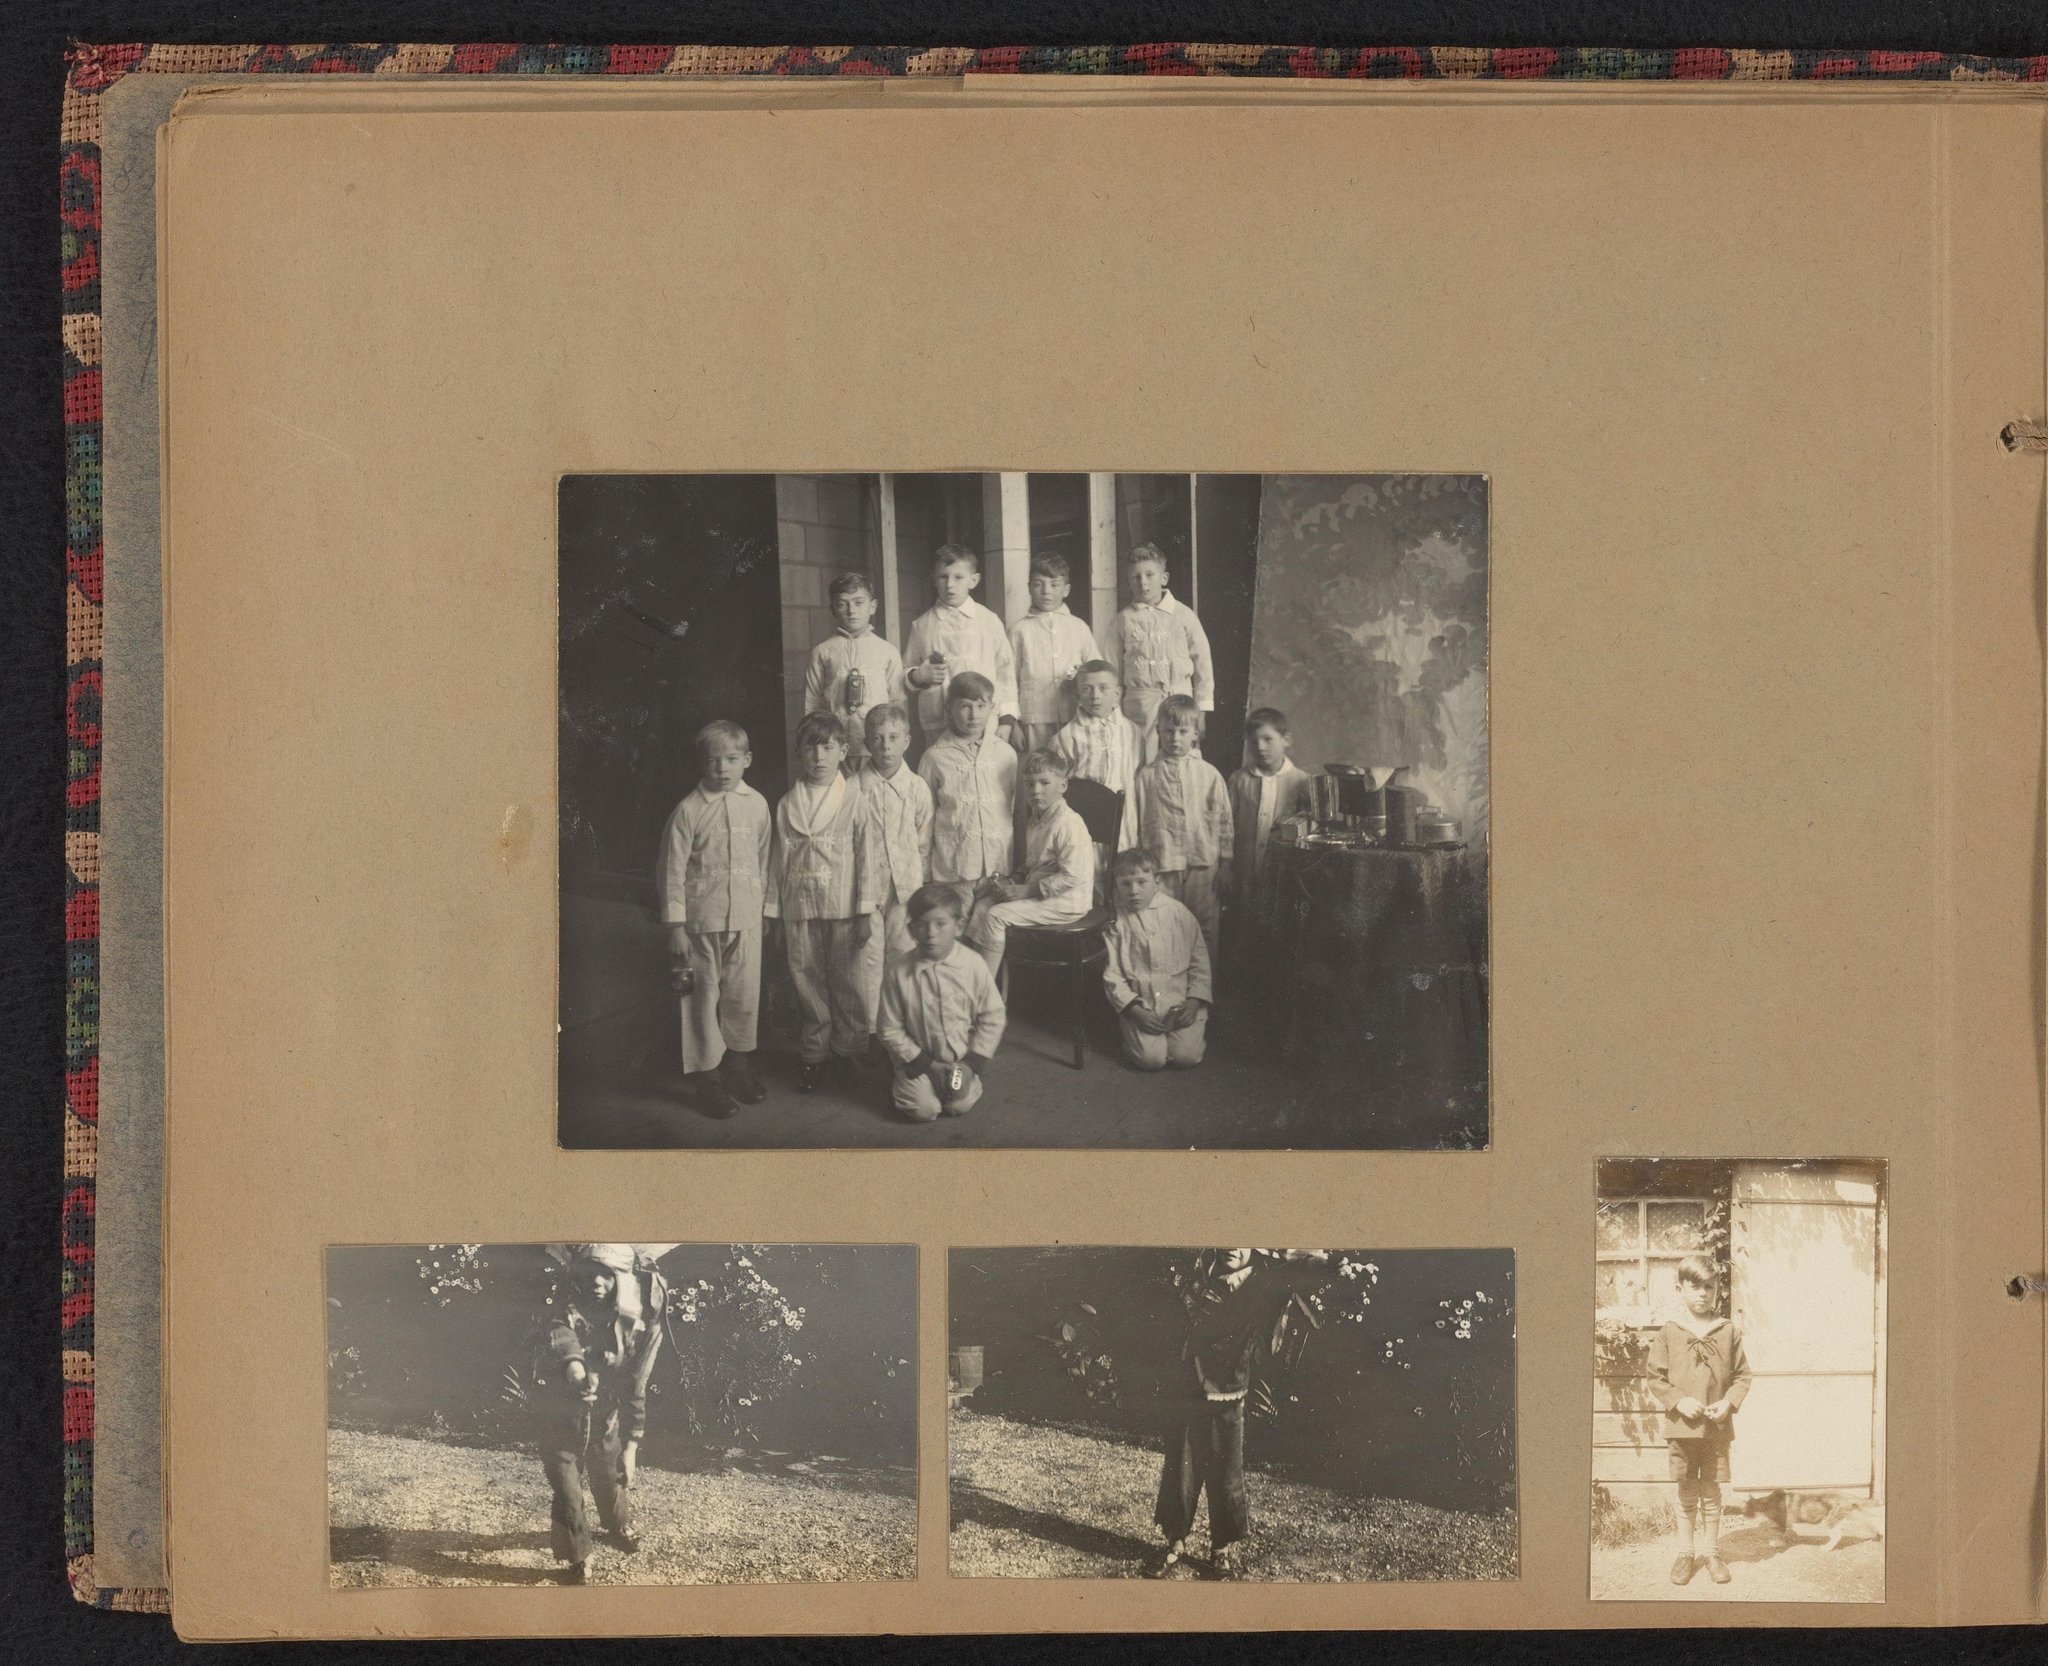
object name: photograph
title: Blad met een foto van jongens in pyama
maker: Anonymous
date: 1920-1927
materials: cardboard, photographic support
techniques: gelatin silver print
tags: amsterdam, max nord, nightwear (with name) (+ children's clothes)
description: Albumblad met vier foto's van jongens, ondermeer in pyama op een logeerpartijtje (?). Onderdeel van het fotoalbum van mevr. Nord-Elshout, de oma van de schenkster Emilie Nord (moeder van Max Nord), met foto's van familieleven uit de periode 1920-1927 in Nederlands-Indië en Nederland.